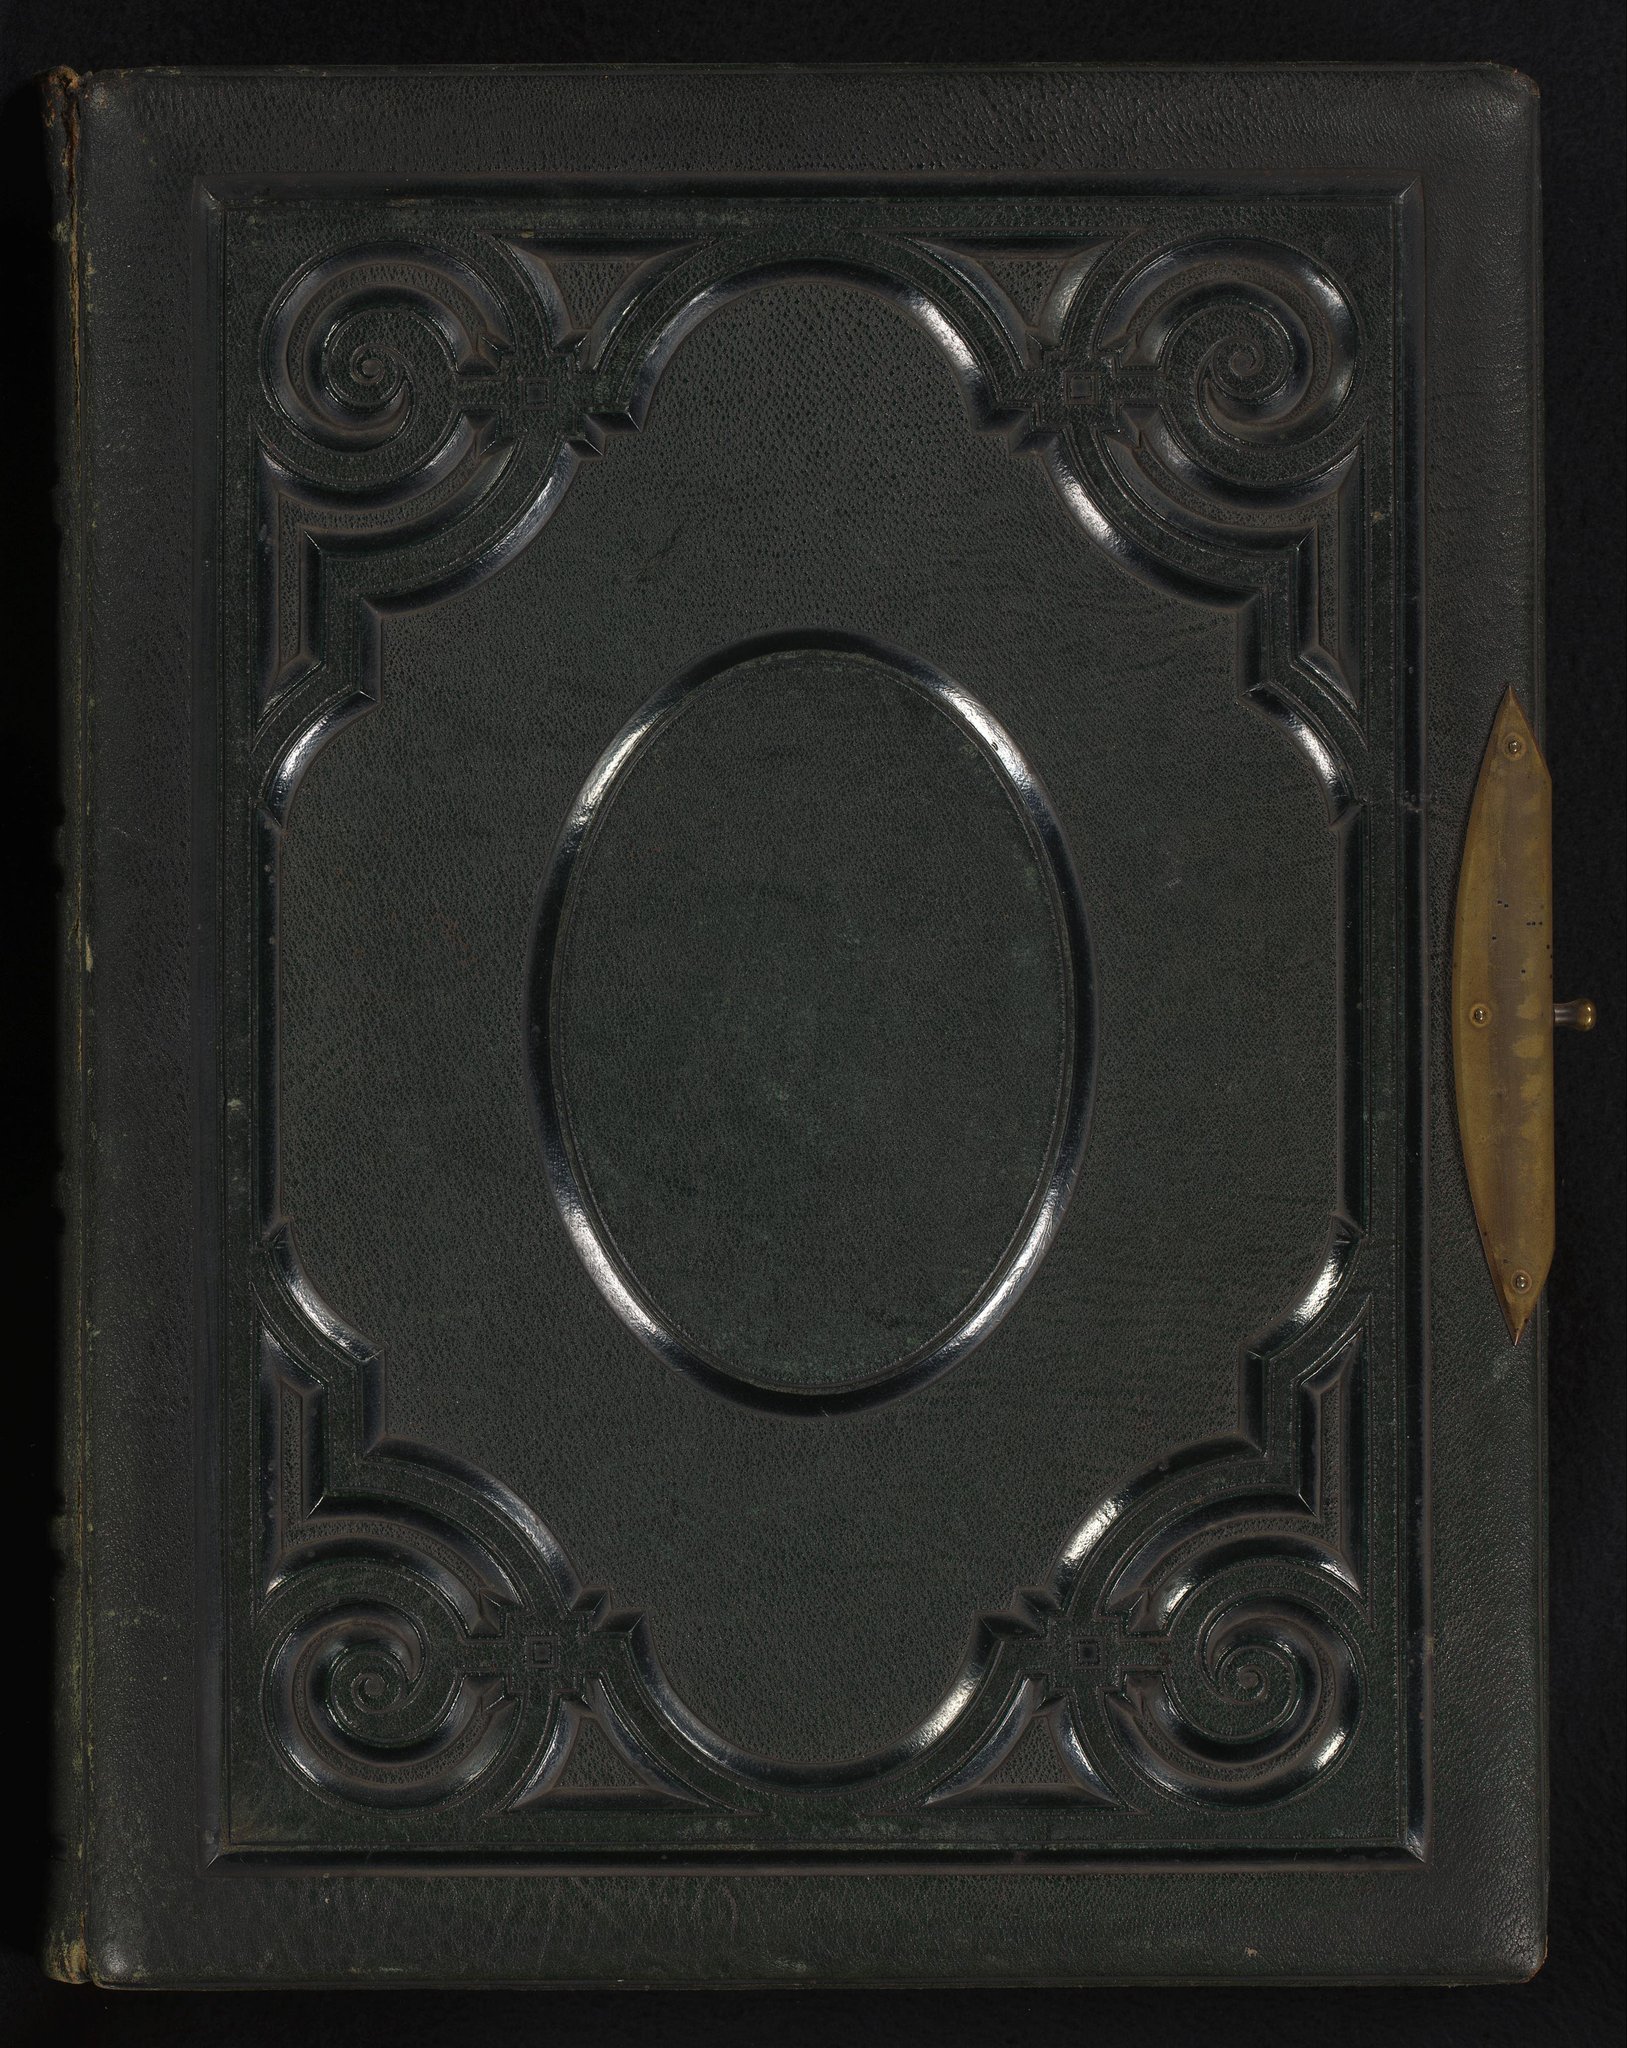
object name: slip in album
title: Nederlands familiealbum met 157 foto's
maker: Anonymous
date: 1900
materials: cardboard, leather, metal, paper, photographic support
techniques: albumen print, carbon print, gelatin silver print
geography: netherlands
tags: historical persons - bb - woman, child, historical persons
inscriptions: collector's mark: ‘DIENST/ VERSPREIDE/ RIJKSKOLLEKTIES/ (...) A 1030’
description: Fotoalbum met 48 pagina's met in totaal 157 foto's. Het album bevat 12 kabinetfoto's en 144 cartes-de-visite in met gouden lijnen omkaderde passe-partouts en 1 los miniatuurportret. Iedere pagina bevat ofwel een passe-partout voor een kabinetfoto, ofwel 4 passe-partouts voor cartes-de-visite. Afgebeeld zijn portretten van onbekende mannen, vrouwen en kinderen, vermoedelijk uit een familie. Bij 2 cartes-de-visite staat op verso een naam, vermoedelijk van de geportretteerde. De foto's zijn gemaakt door verschillende Nederlandse fotografen, waaronder Elkan Sanders Jr, Benjamin Sanders, Thomas Martin Staas en W.B. Bekkering. Van 9 foto's is de fotograaf anoniem.